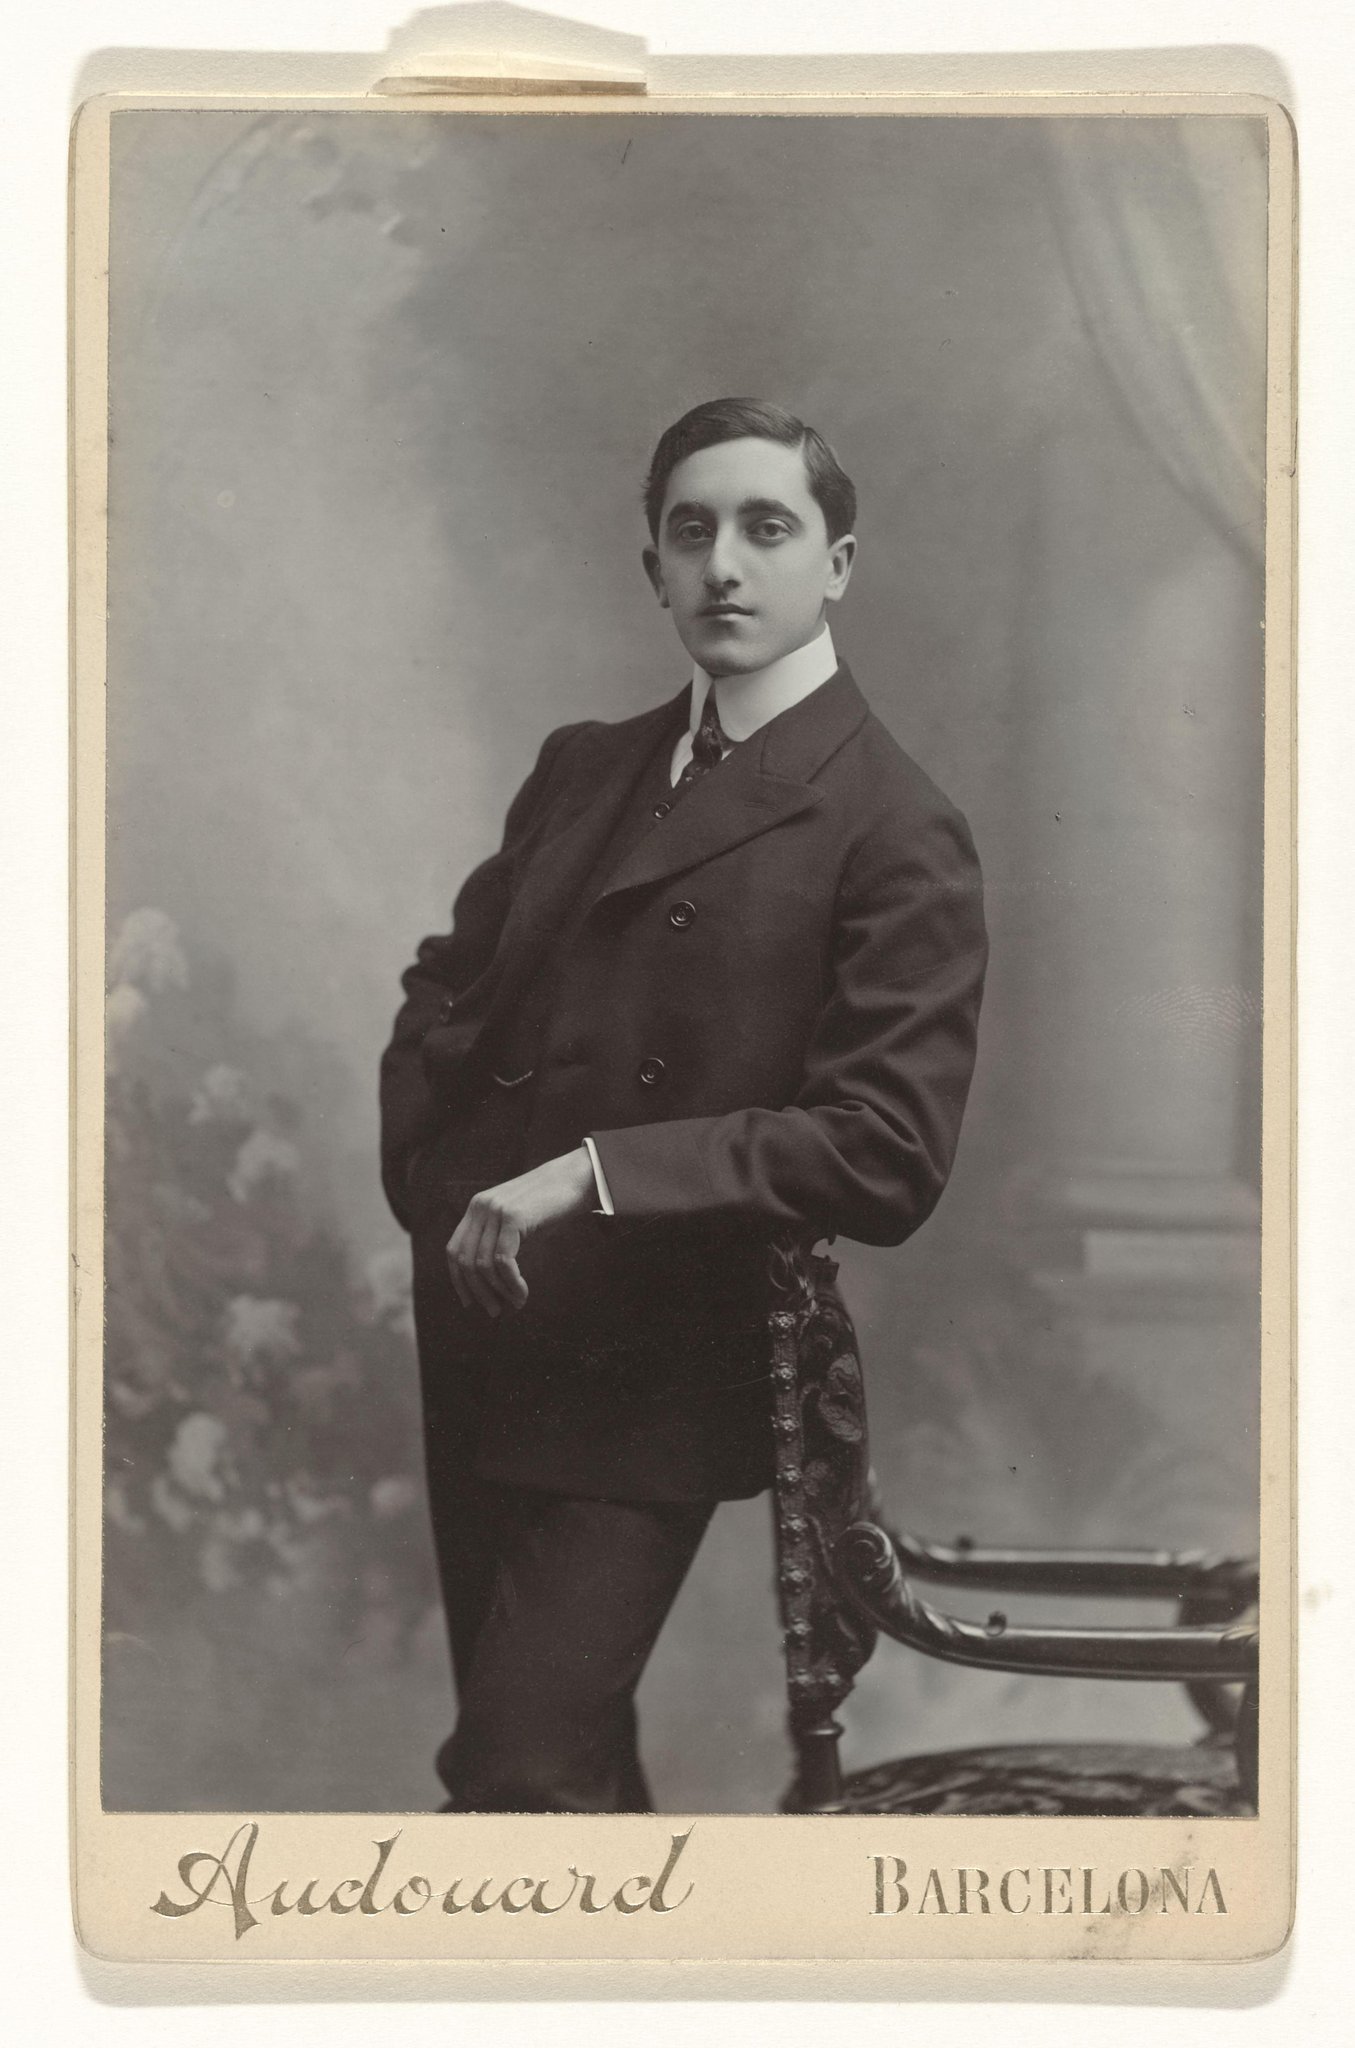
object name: photograph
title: Photographs from the Estate of Isabel Wachenheimer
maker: pau audouard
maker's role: fotograaf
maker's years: 1857-1918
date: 1901-1906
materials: photographic support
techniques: gelatin silver print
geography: barcelona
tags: eugen wachenheimer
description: The German Eugen Wachenheimer had a brilliant career at the Deutsche Bank and served as a naval officer in the First World War. In 1922 he married Else Moos. The Anti-Jewish laws instituted by the Nazi regime forced them to flee to the Netherlands in 1937. The photograph at the lower right is the last one taken of Eugen. He stands with his back to the camera behind his daughter. Eugen and Else were gassed at Auschwitz-Birkenau in 1944.